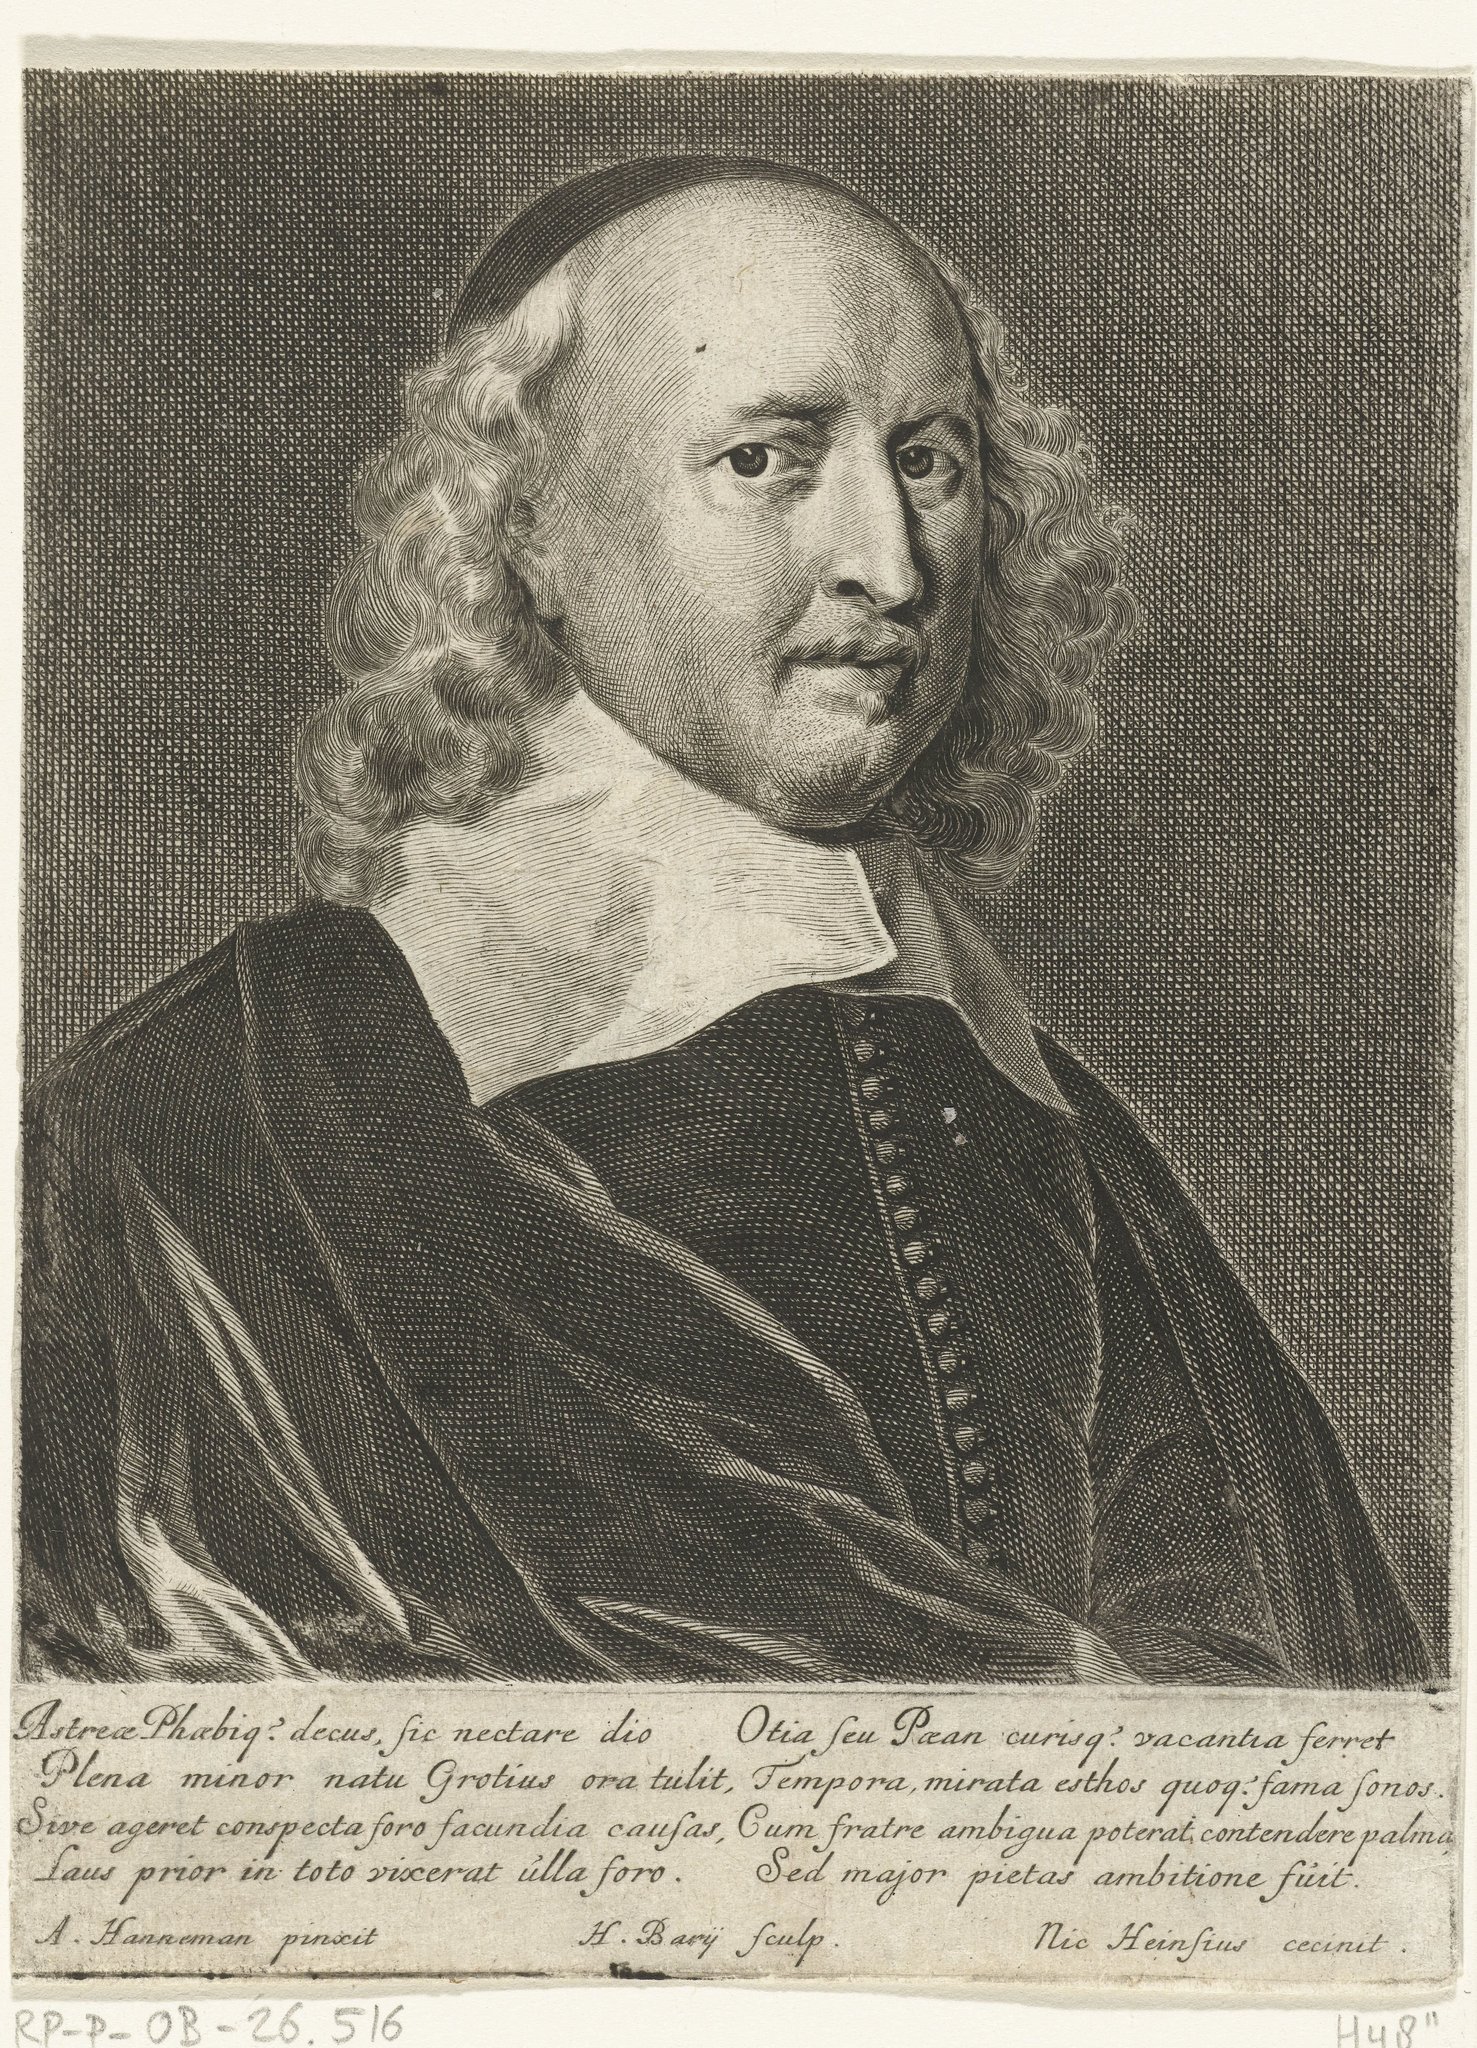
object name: print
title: Portret van Willem de Groot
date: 1657-1707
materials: paper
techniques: engraving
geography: netherlands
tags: delft, willem de groot (1597-1662)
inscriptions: collector's mark: Lugt 2228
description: Borstbeeld van Willem de Groot, met een onderschrift van vier regels in het Latijn.